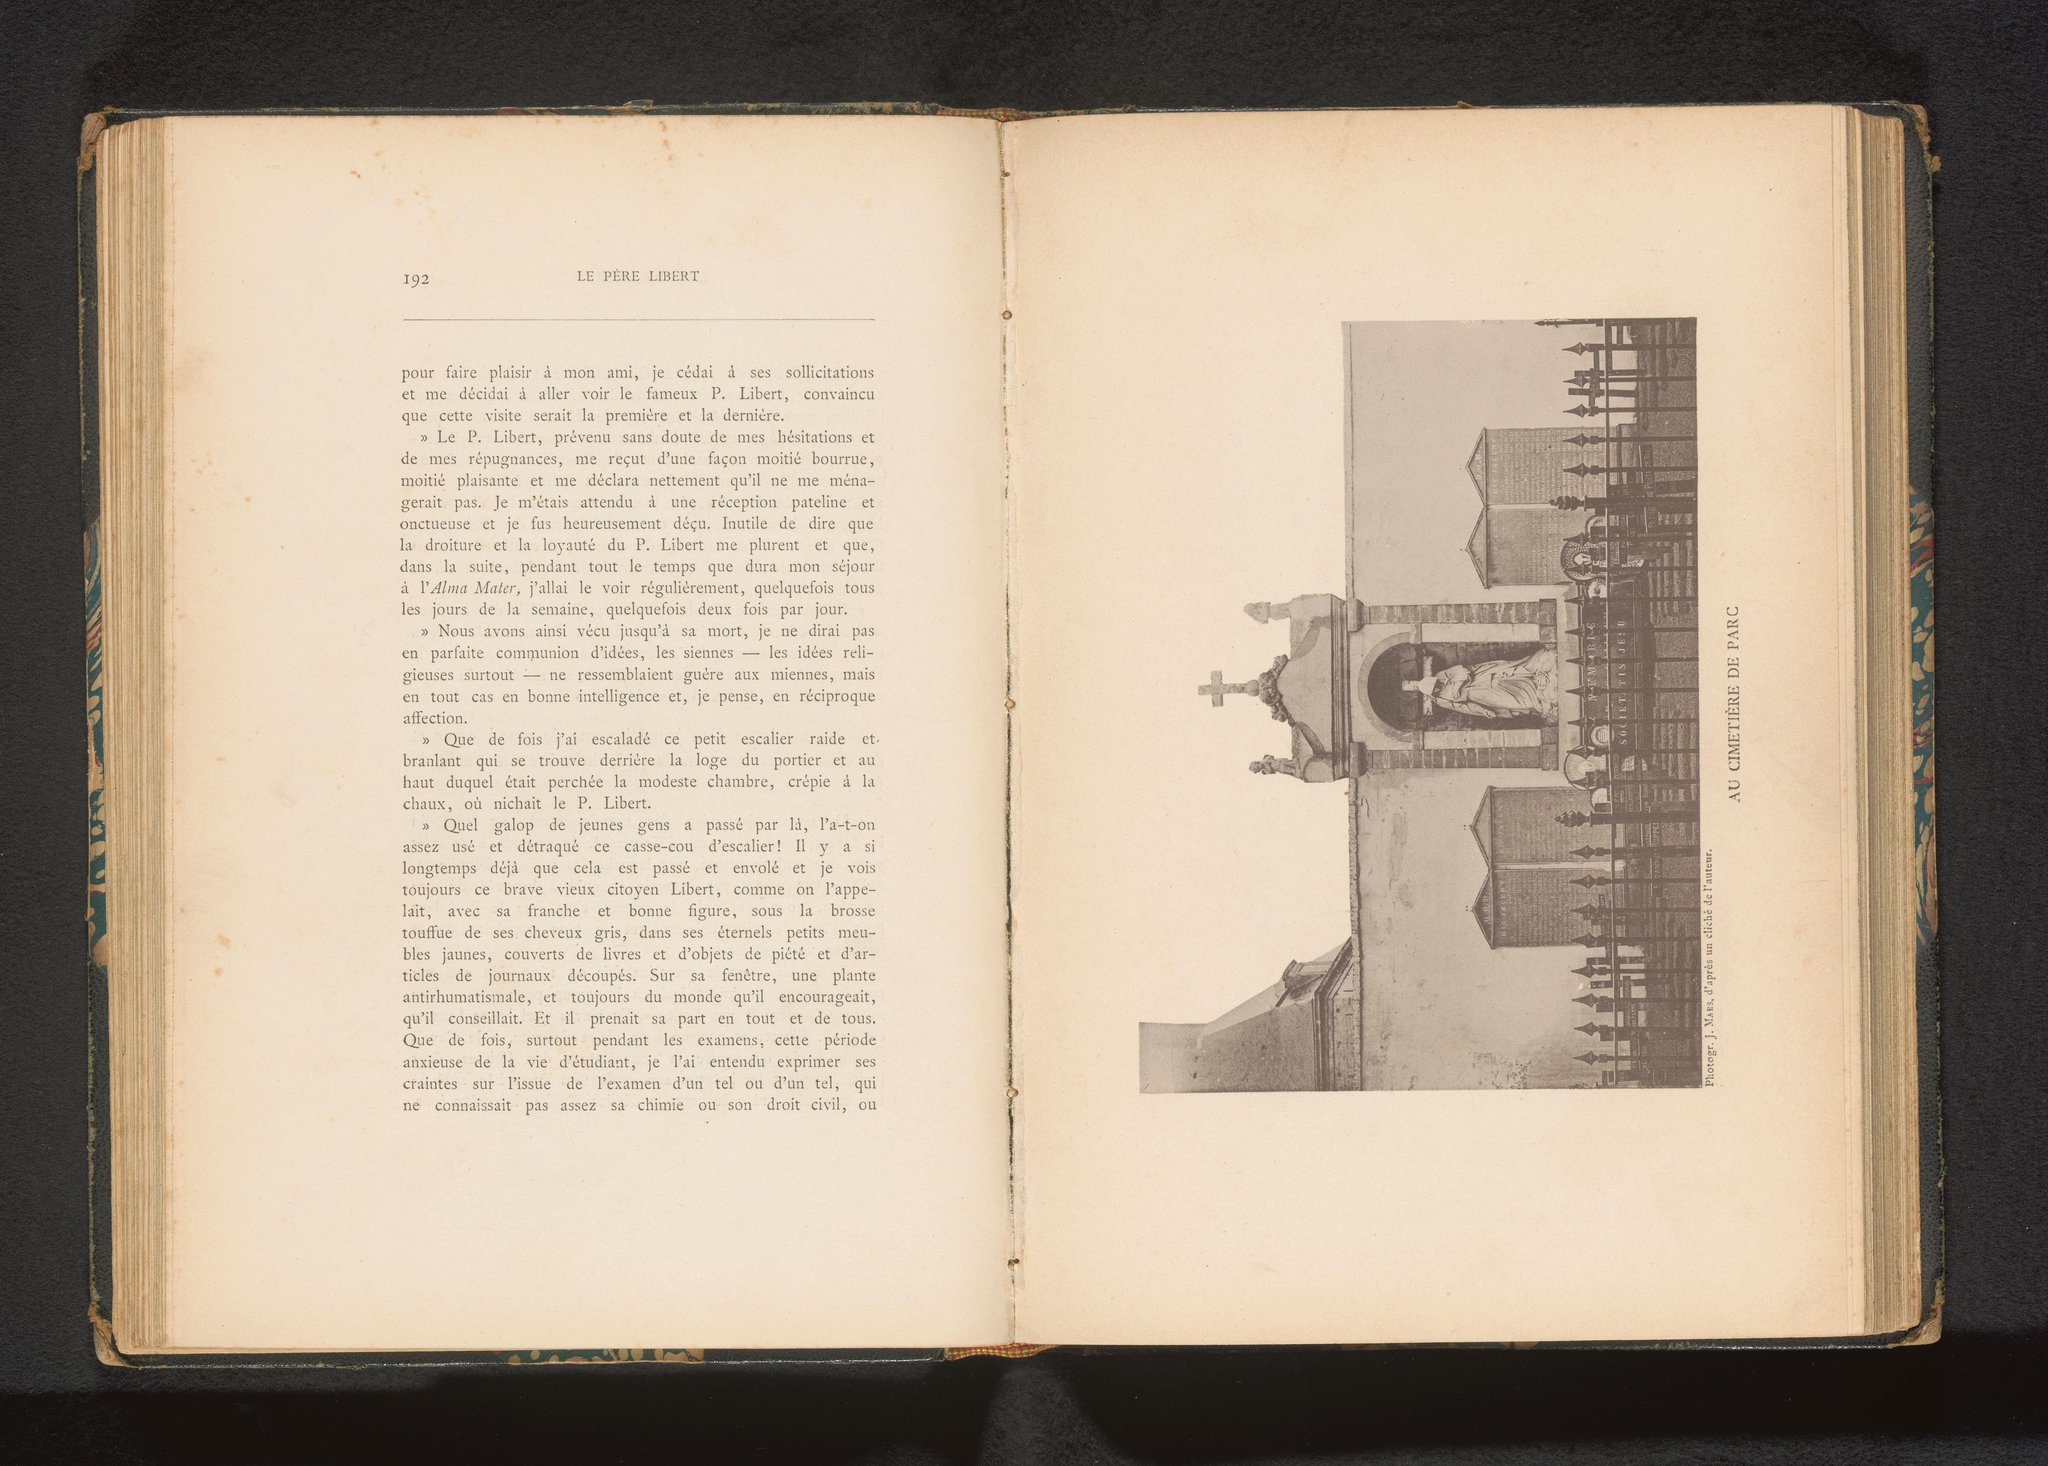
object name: photomechanical print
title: Gezicht op enkele graven, waarvan één vermoedelijk het graf van Vader Libert, vermoedelijk in Scherpenheuvel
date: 1891-1896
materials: paper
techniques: photograph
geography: antwerp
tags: grave, tomb, scherpenheuvel